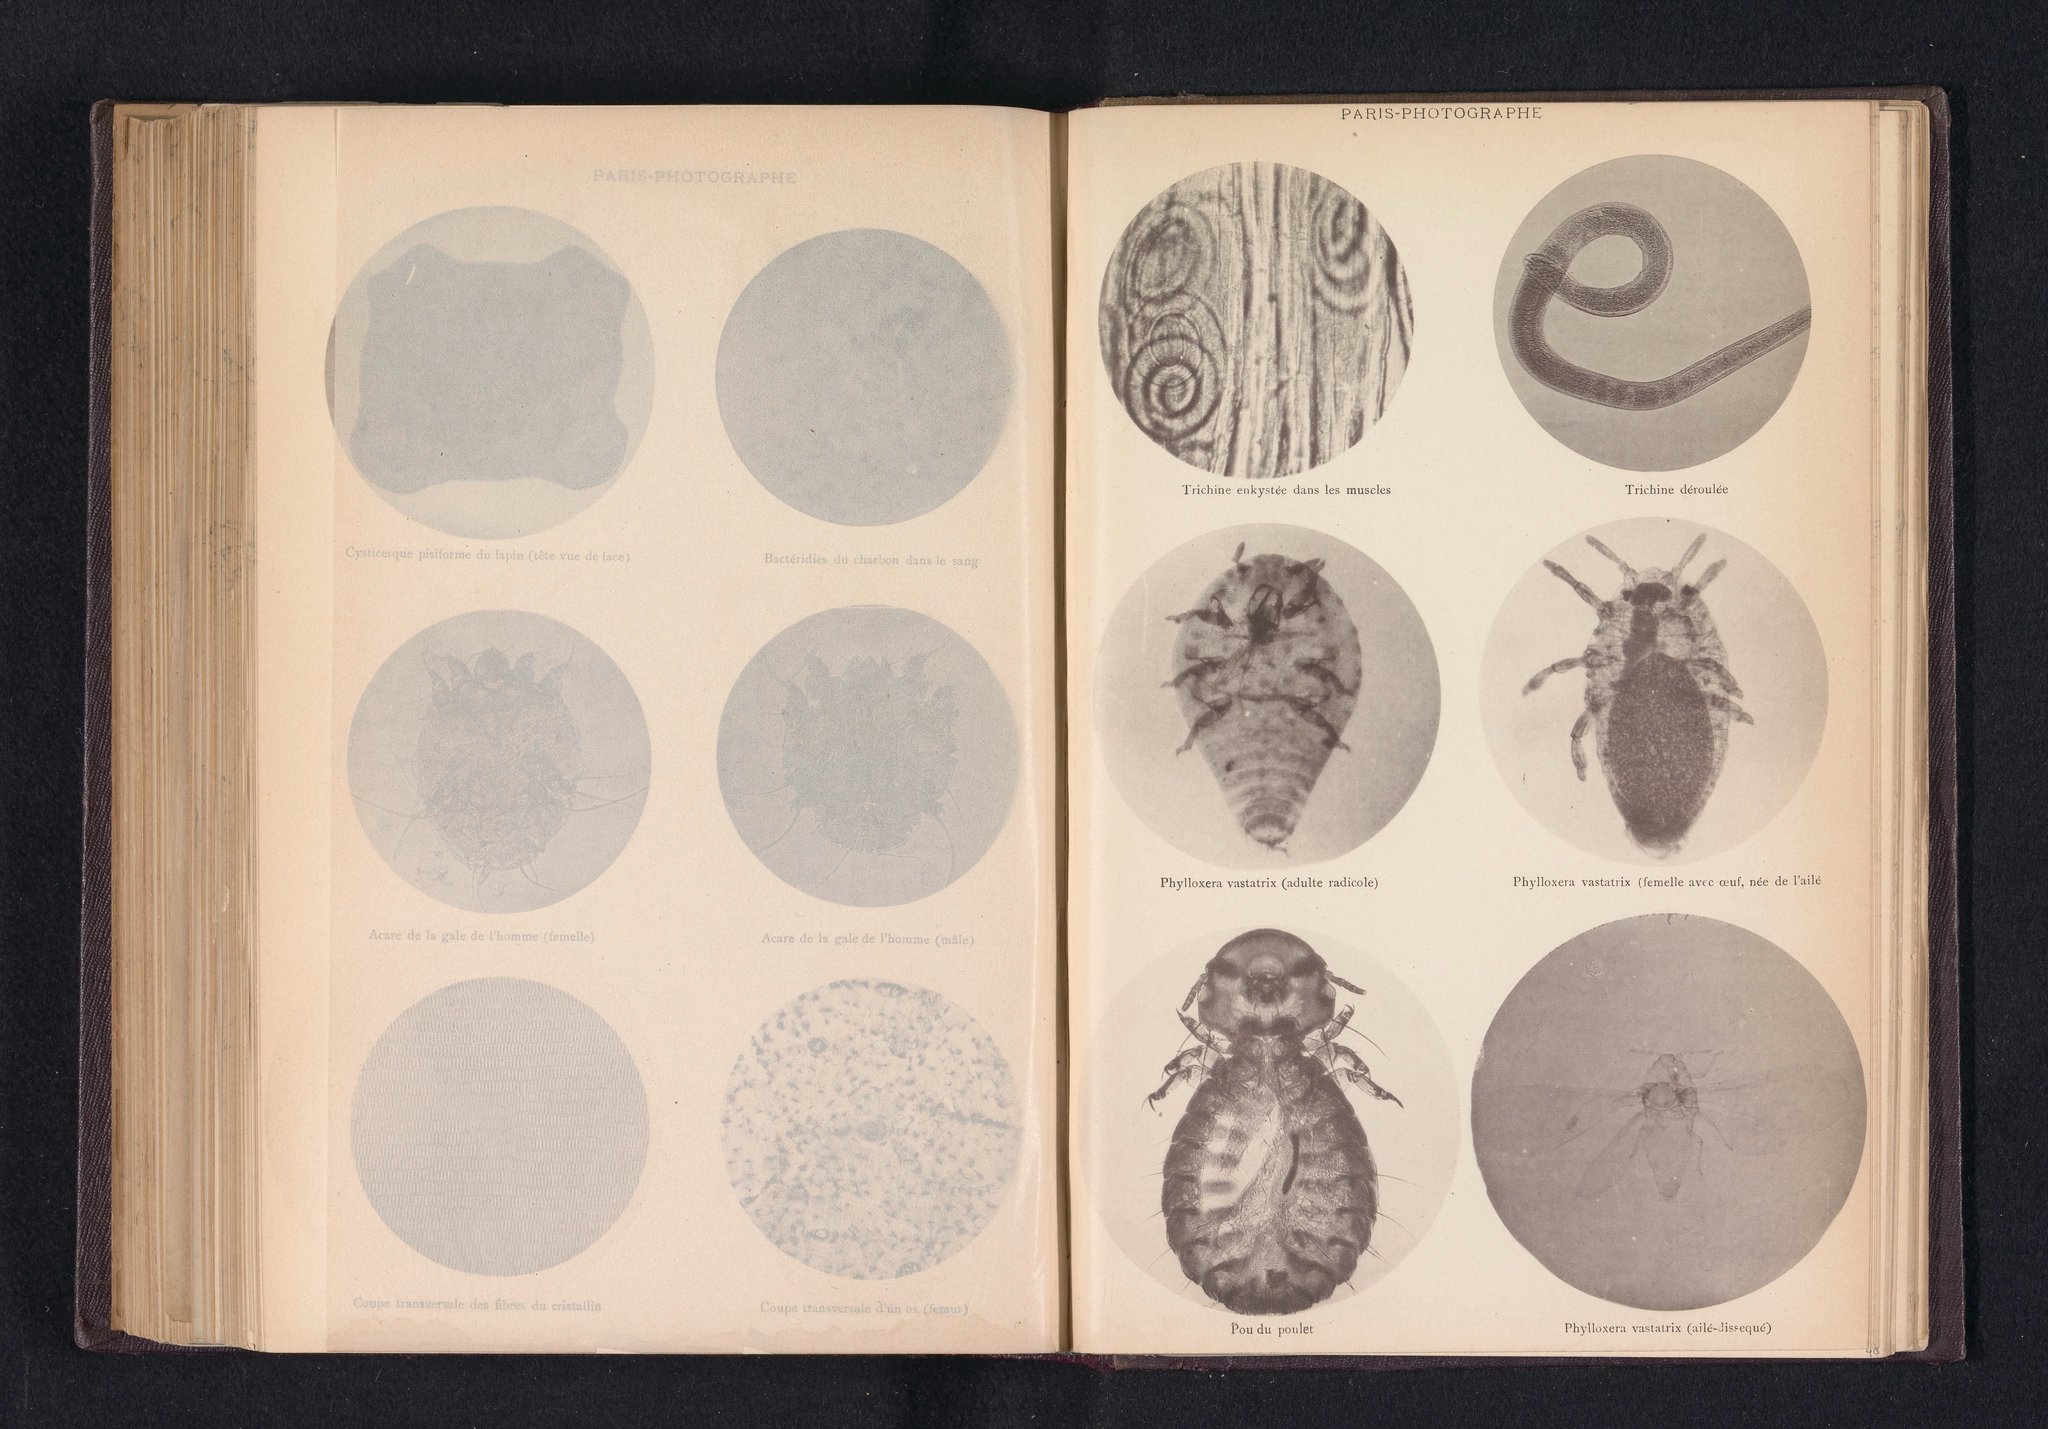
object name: photomechanical print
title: Overzicht van zes microscopische vergrotingen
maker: Anonymous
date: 1881-1891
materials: paper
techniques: photograph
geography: france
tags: worms, insects: louse, microscope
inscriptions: inscription: ‘Trichine enkystée (...) Phylloxera vastatrix (aillé-dissequé)’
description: Boven twee haarwormen, midden twee bladluizen, onder twee bladluizen.